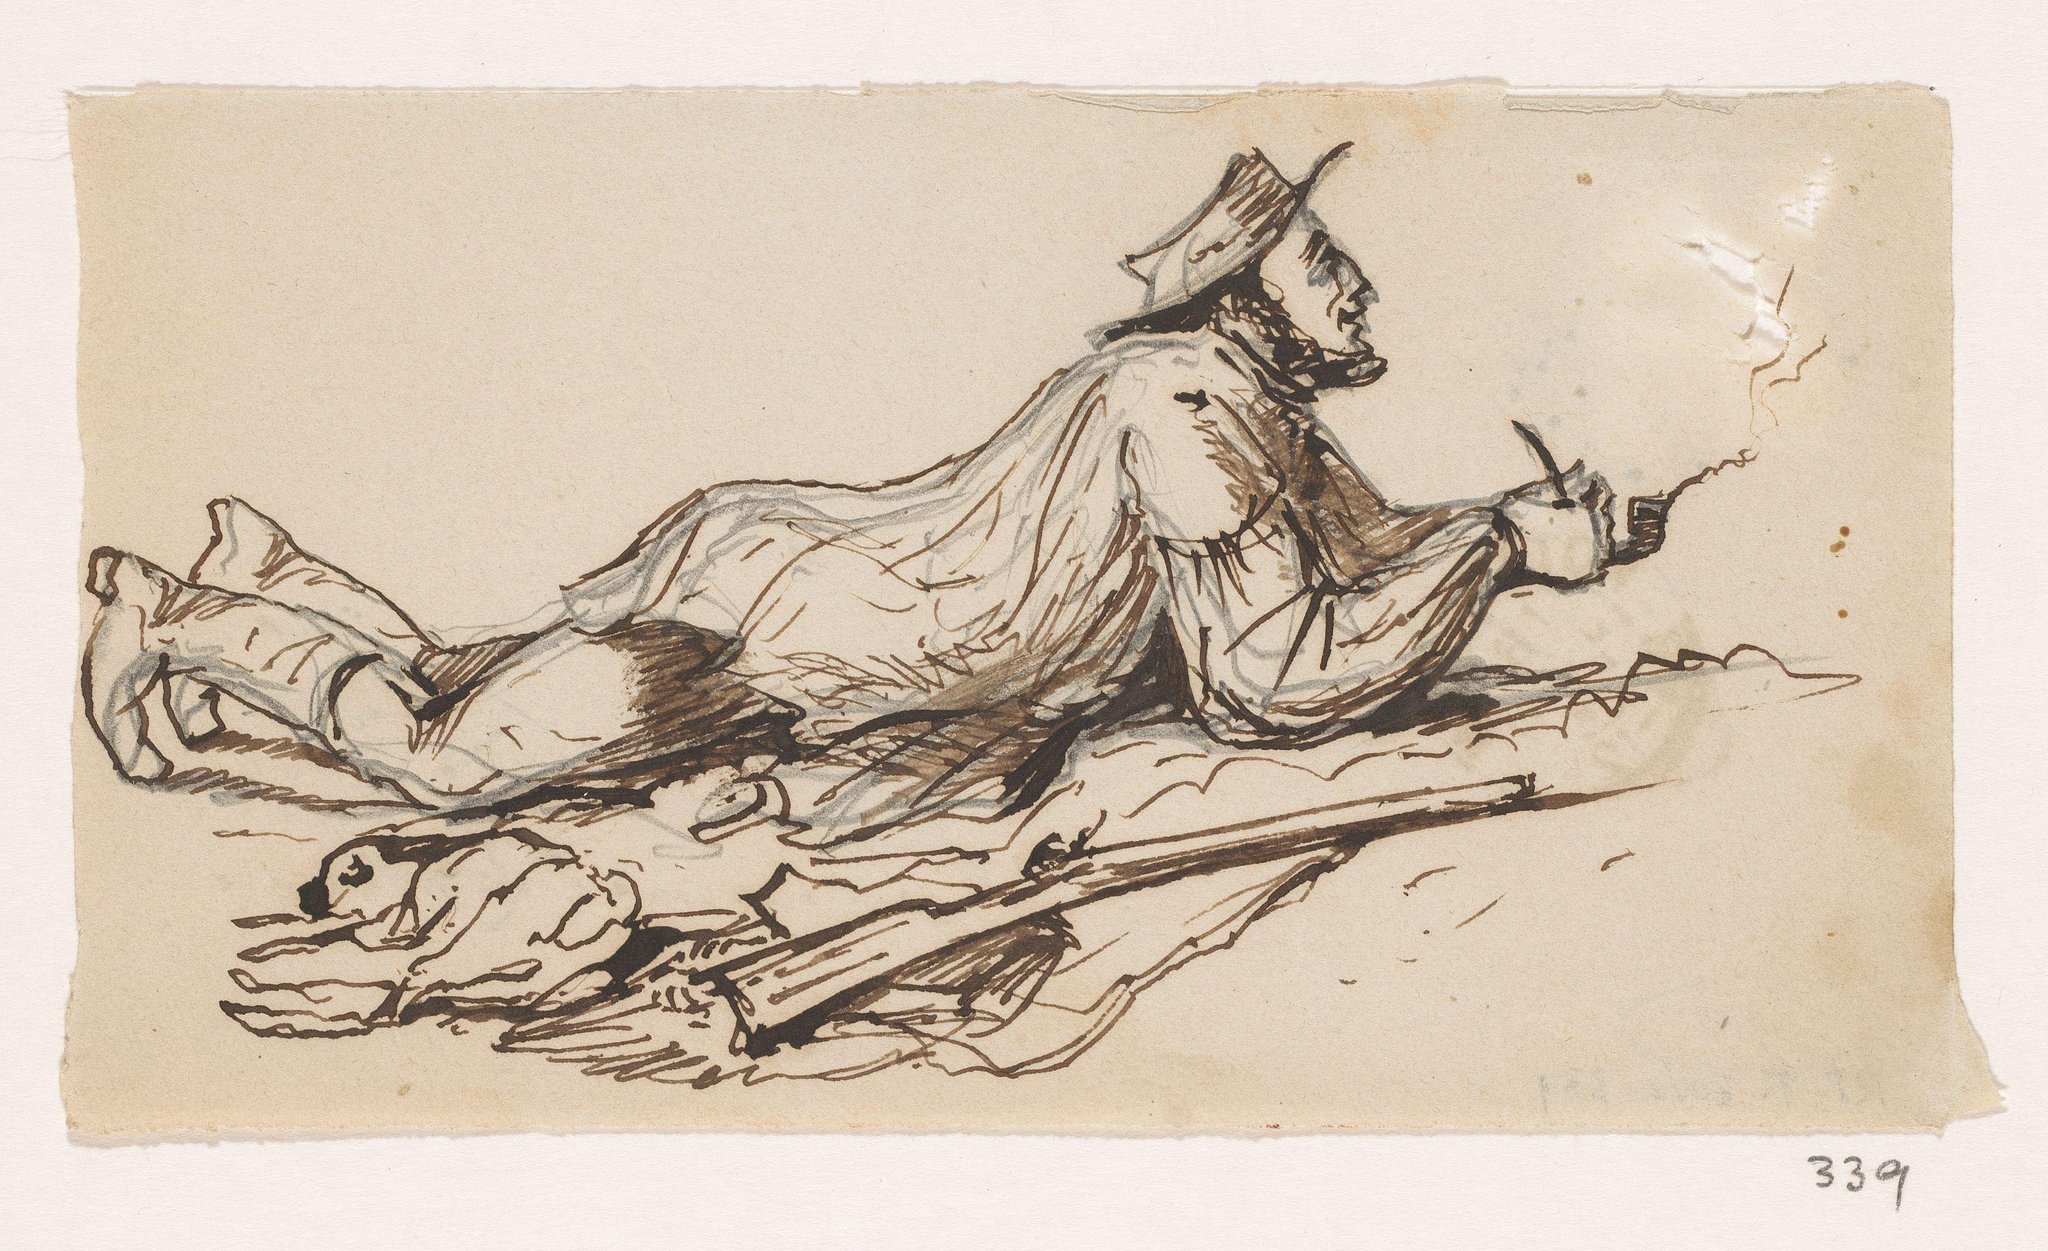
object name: drawing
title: Rustende jager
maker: johannes tavenraat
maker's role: draughtsman, painter, print maker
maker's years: 1809-1881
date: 1840-1880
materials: ink, paper, pencil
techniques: pen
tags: hare-hunting, rabbit-hunting, hunters resting during the hunt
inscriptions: collector's mark: Lugt 2228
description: Op de grond liggende rustende jager. Getekend op een deel van een envelop gericht aan J. Tavenraat.